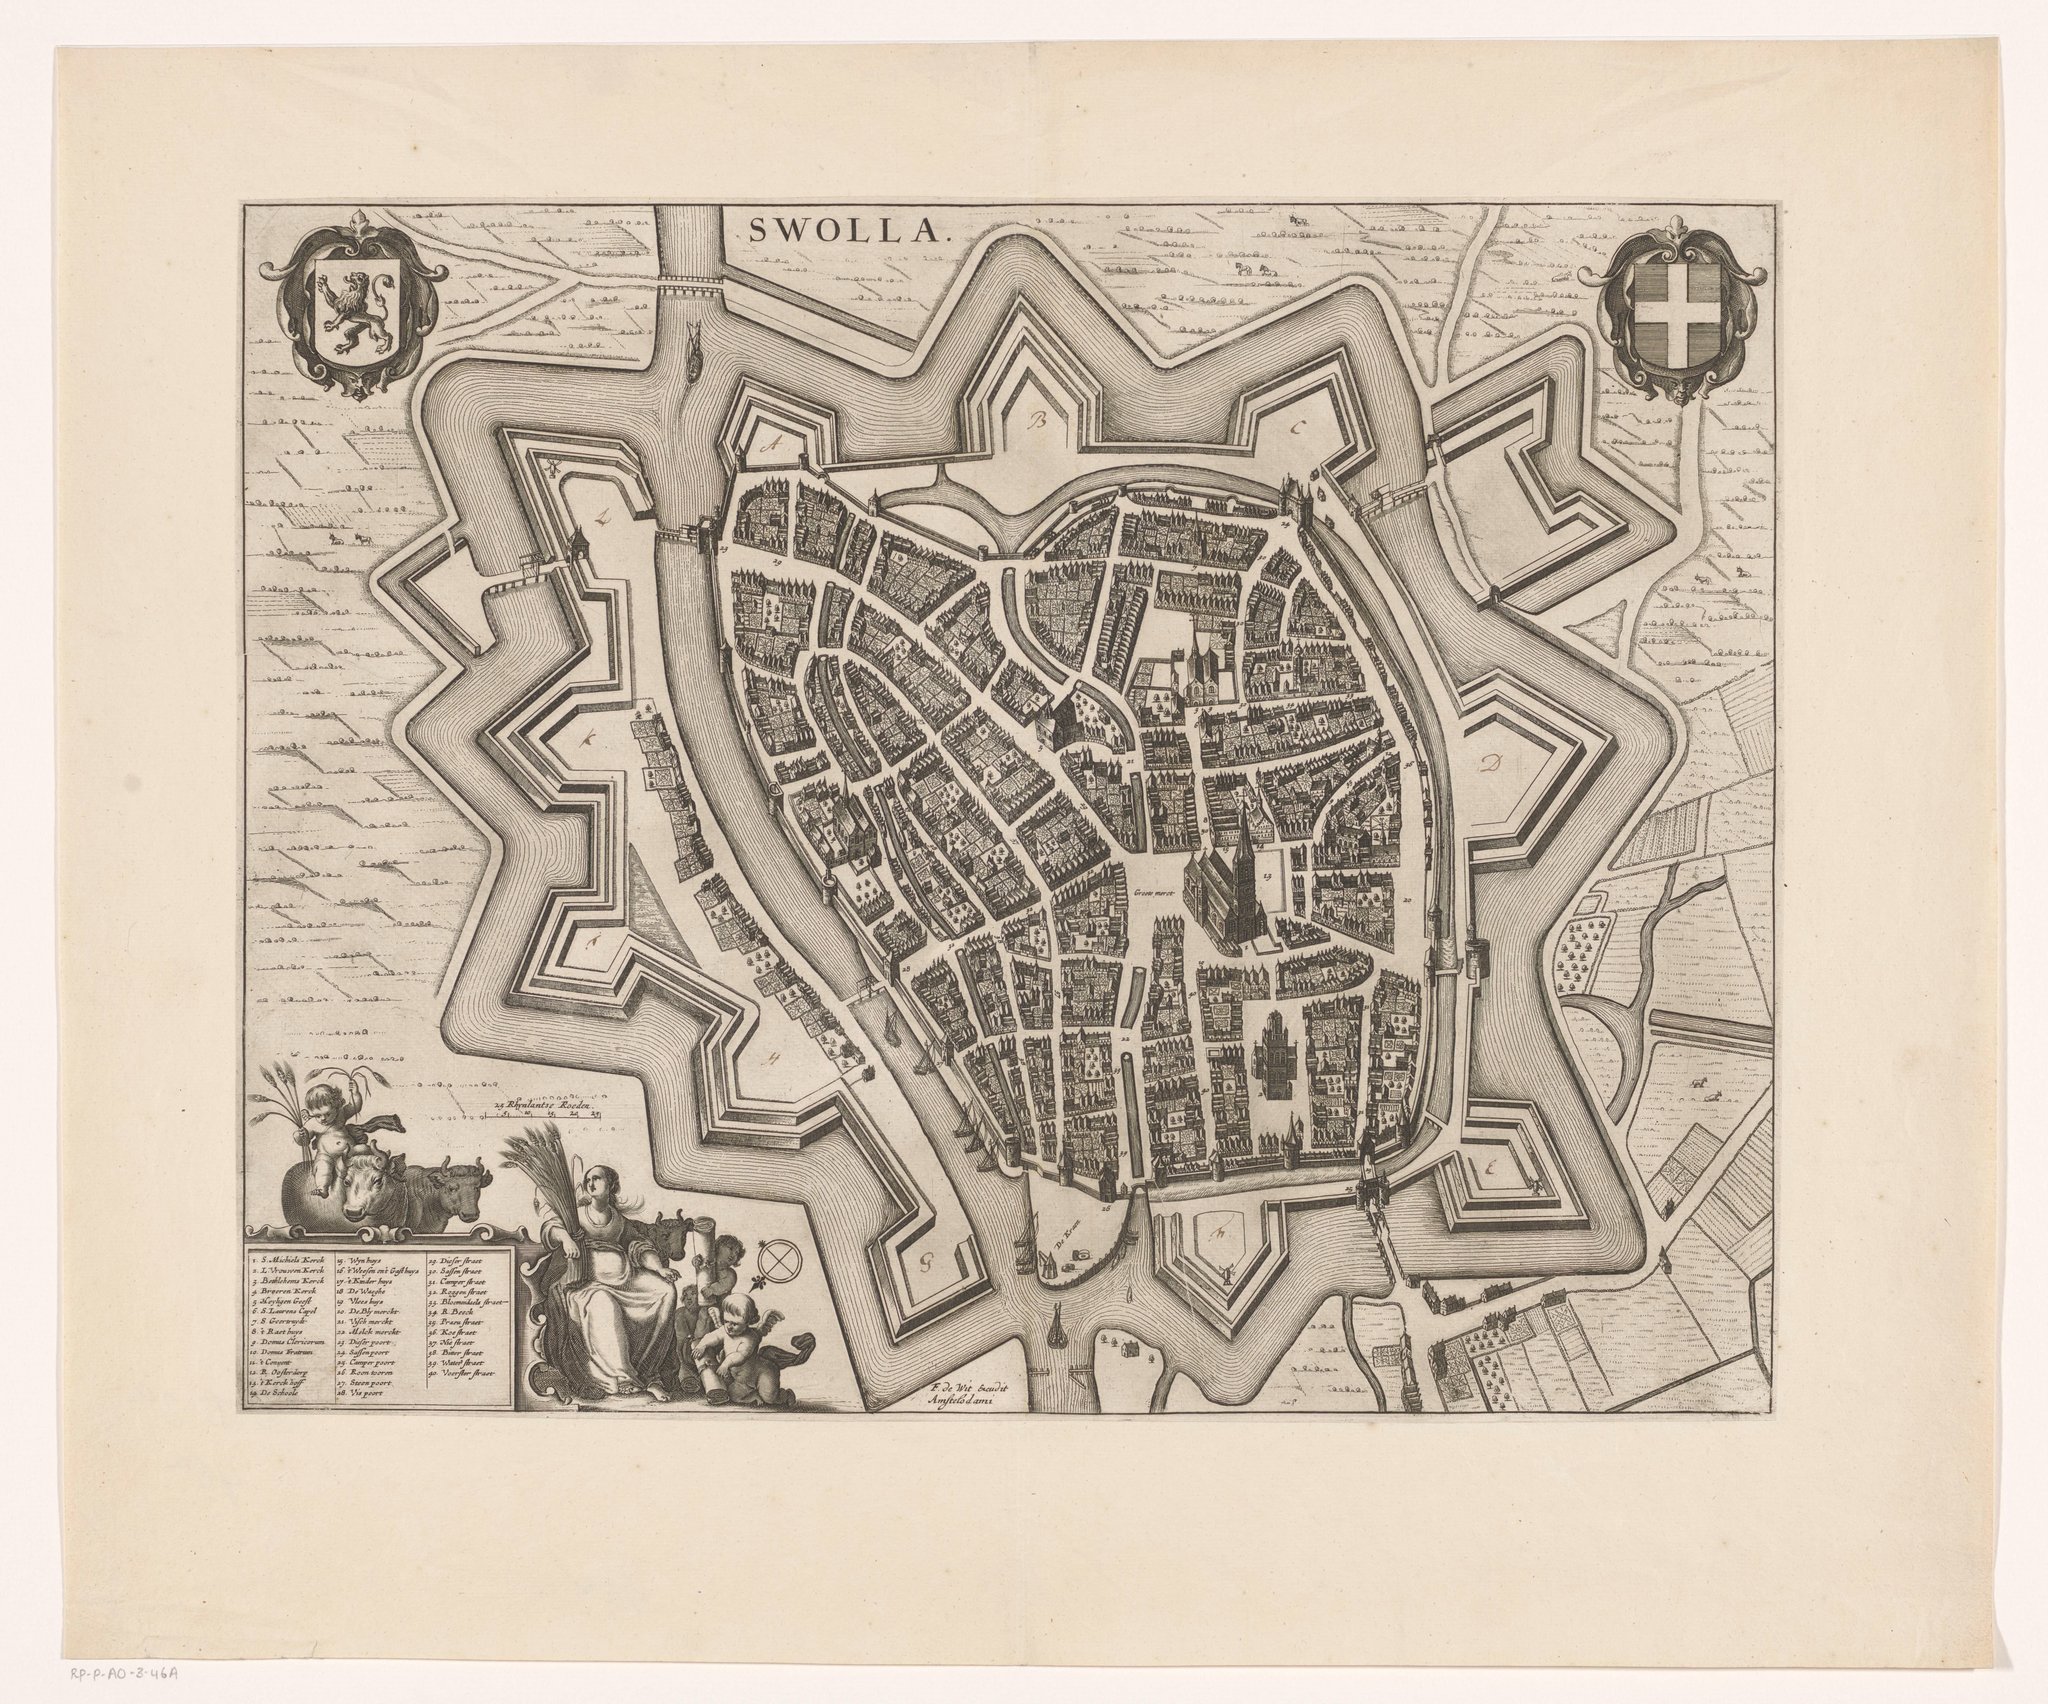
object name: print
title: Plattegrond van Zwolle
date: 1657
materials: ink, paper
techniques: engraving, etching, pen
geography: amsterdam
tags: coat of arms (as symbol of the state, etc.), (story of) ceres (demeter), cattle, maps of cities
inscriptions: inscription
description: Plattegrond in vogelvluchtperspectief. Linksboven het wapen van Overijssel. Linksonder legenda, daaromheen putti, vee en een vrouwfiguur met een korenschoof (mogelijk Ceres). Daarboven een schaalstok: 15 Rhynlantse roeden. Rechtsboven het wapen van Zwolle.